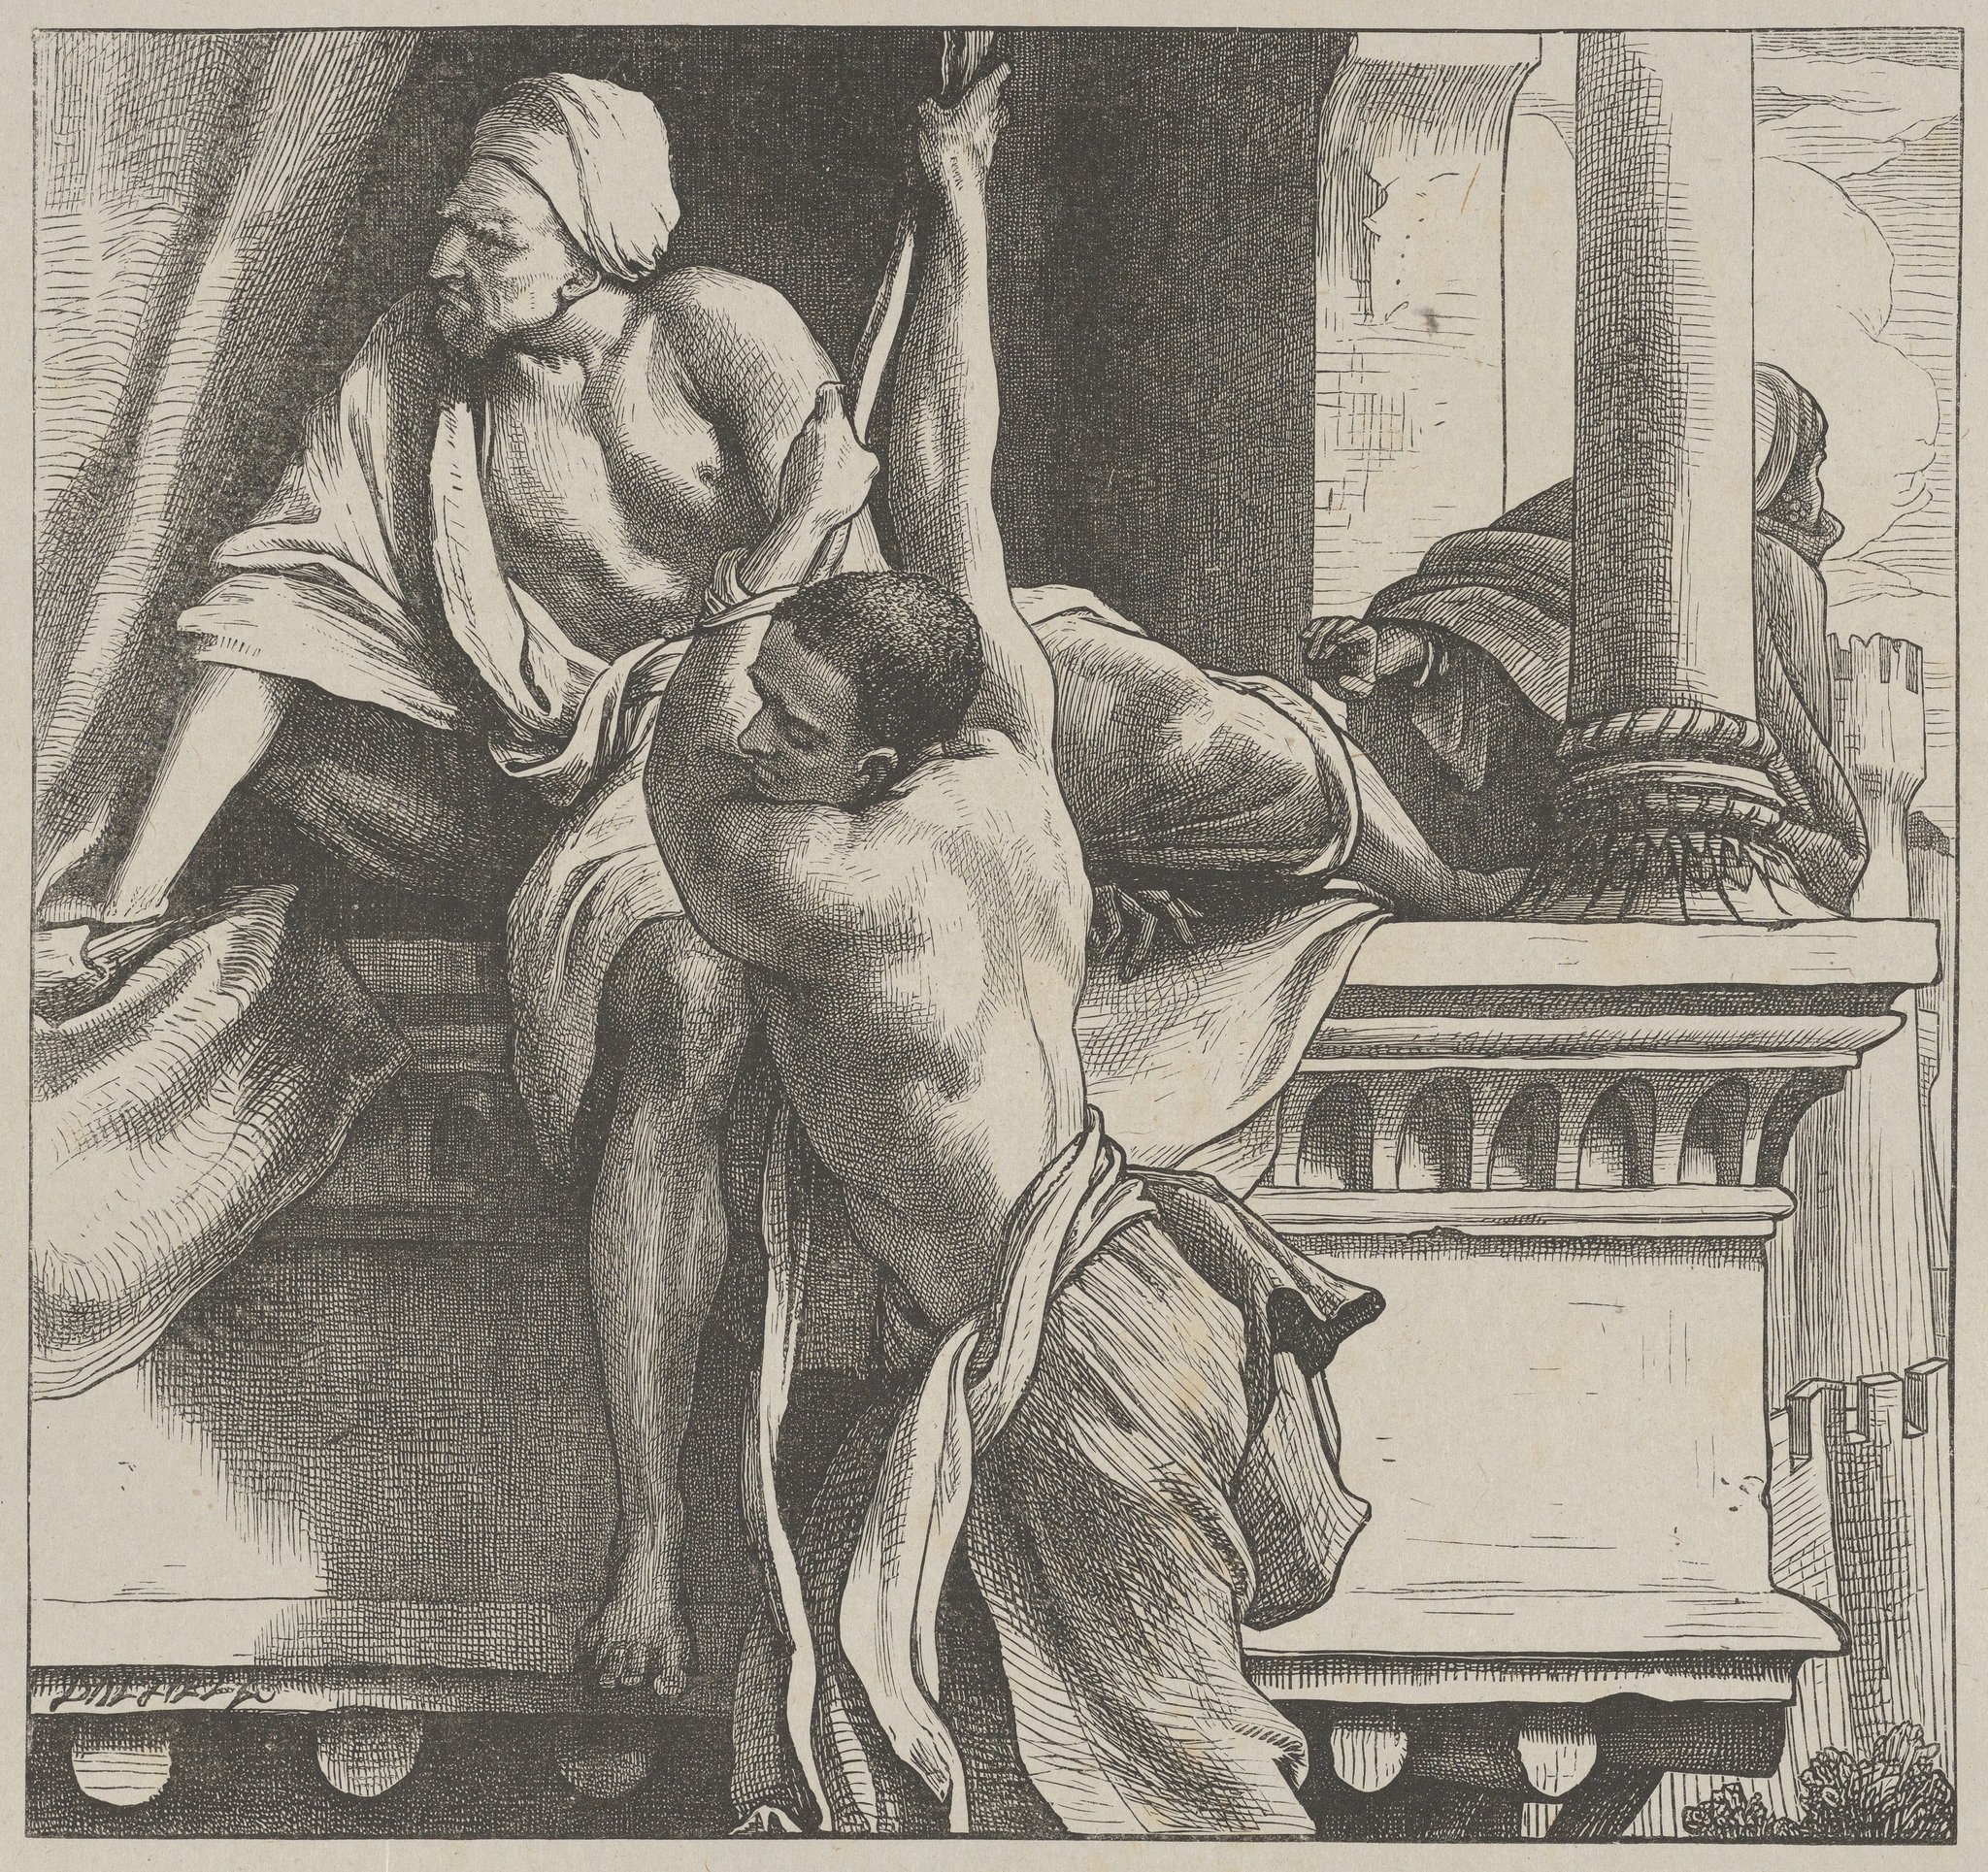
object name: print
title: The Spies Escape, from "Dalziels' Bible Gallery"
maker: frederic, lord leighton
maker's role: artist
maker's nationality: british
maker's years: 1830-1896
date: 1865-1881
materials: paper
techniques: engraving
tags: men